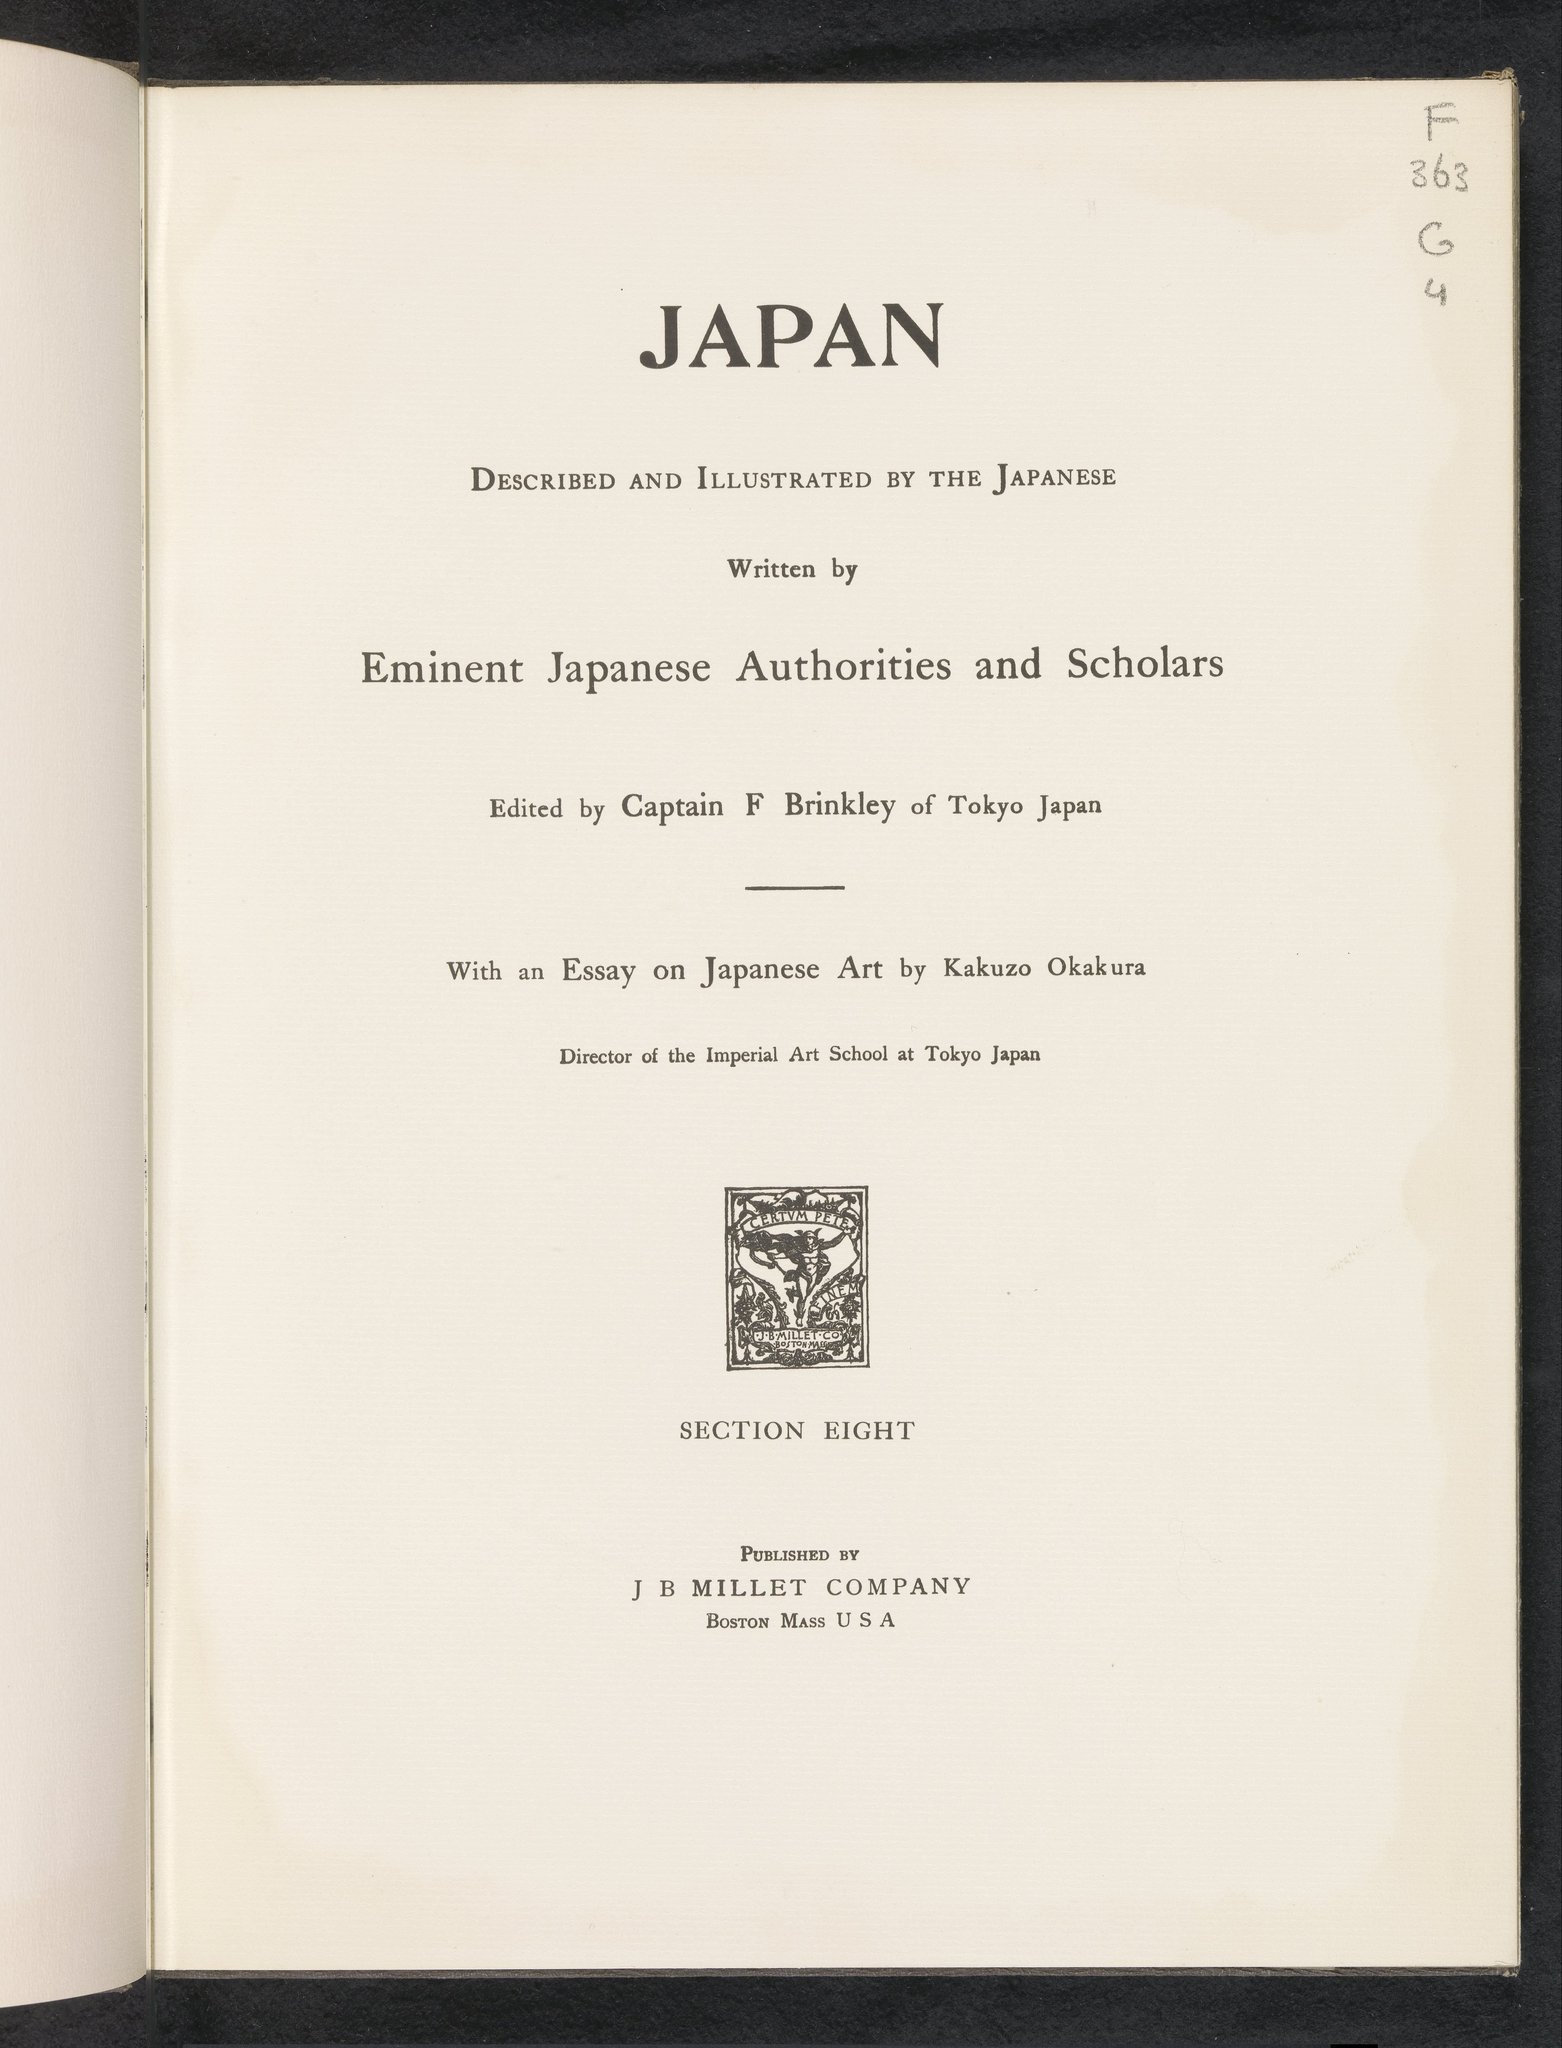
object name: book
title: Japan described and illustrated by the Japanese section eight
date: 1897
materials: cardboard, linen, paper, photographic support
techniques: albumen print, photograph, hand coloring, printing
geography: boston